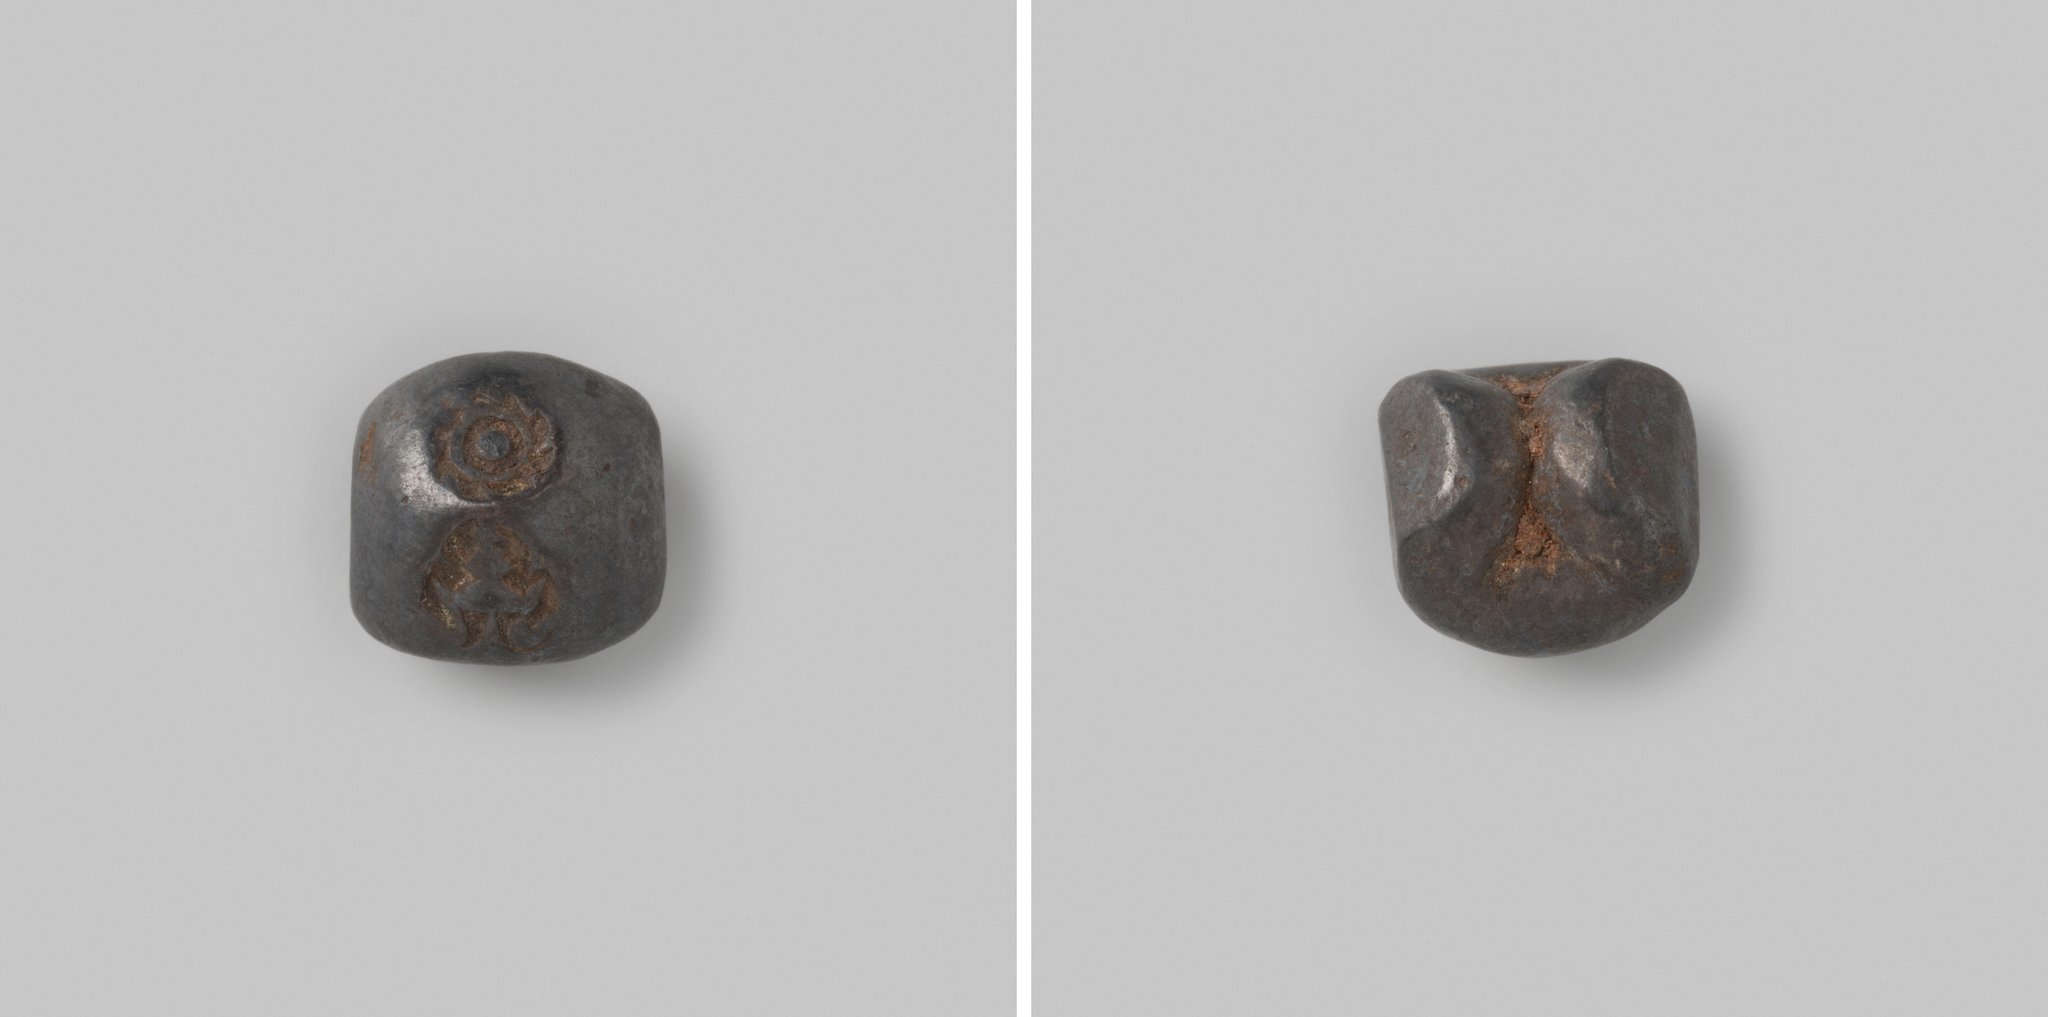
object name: coin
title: Thailand,1/4 tical of salung,1650-1850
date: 1650-1850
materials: silver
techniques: casting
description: Zilveren, korrelvormige munt. voorzien van twee instempelingen (kra): chakra en pagode.